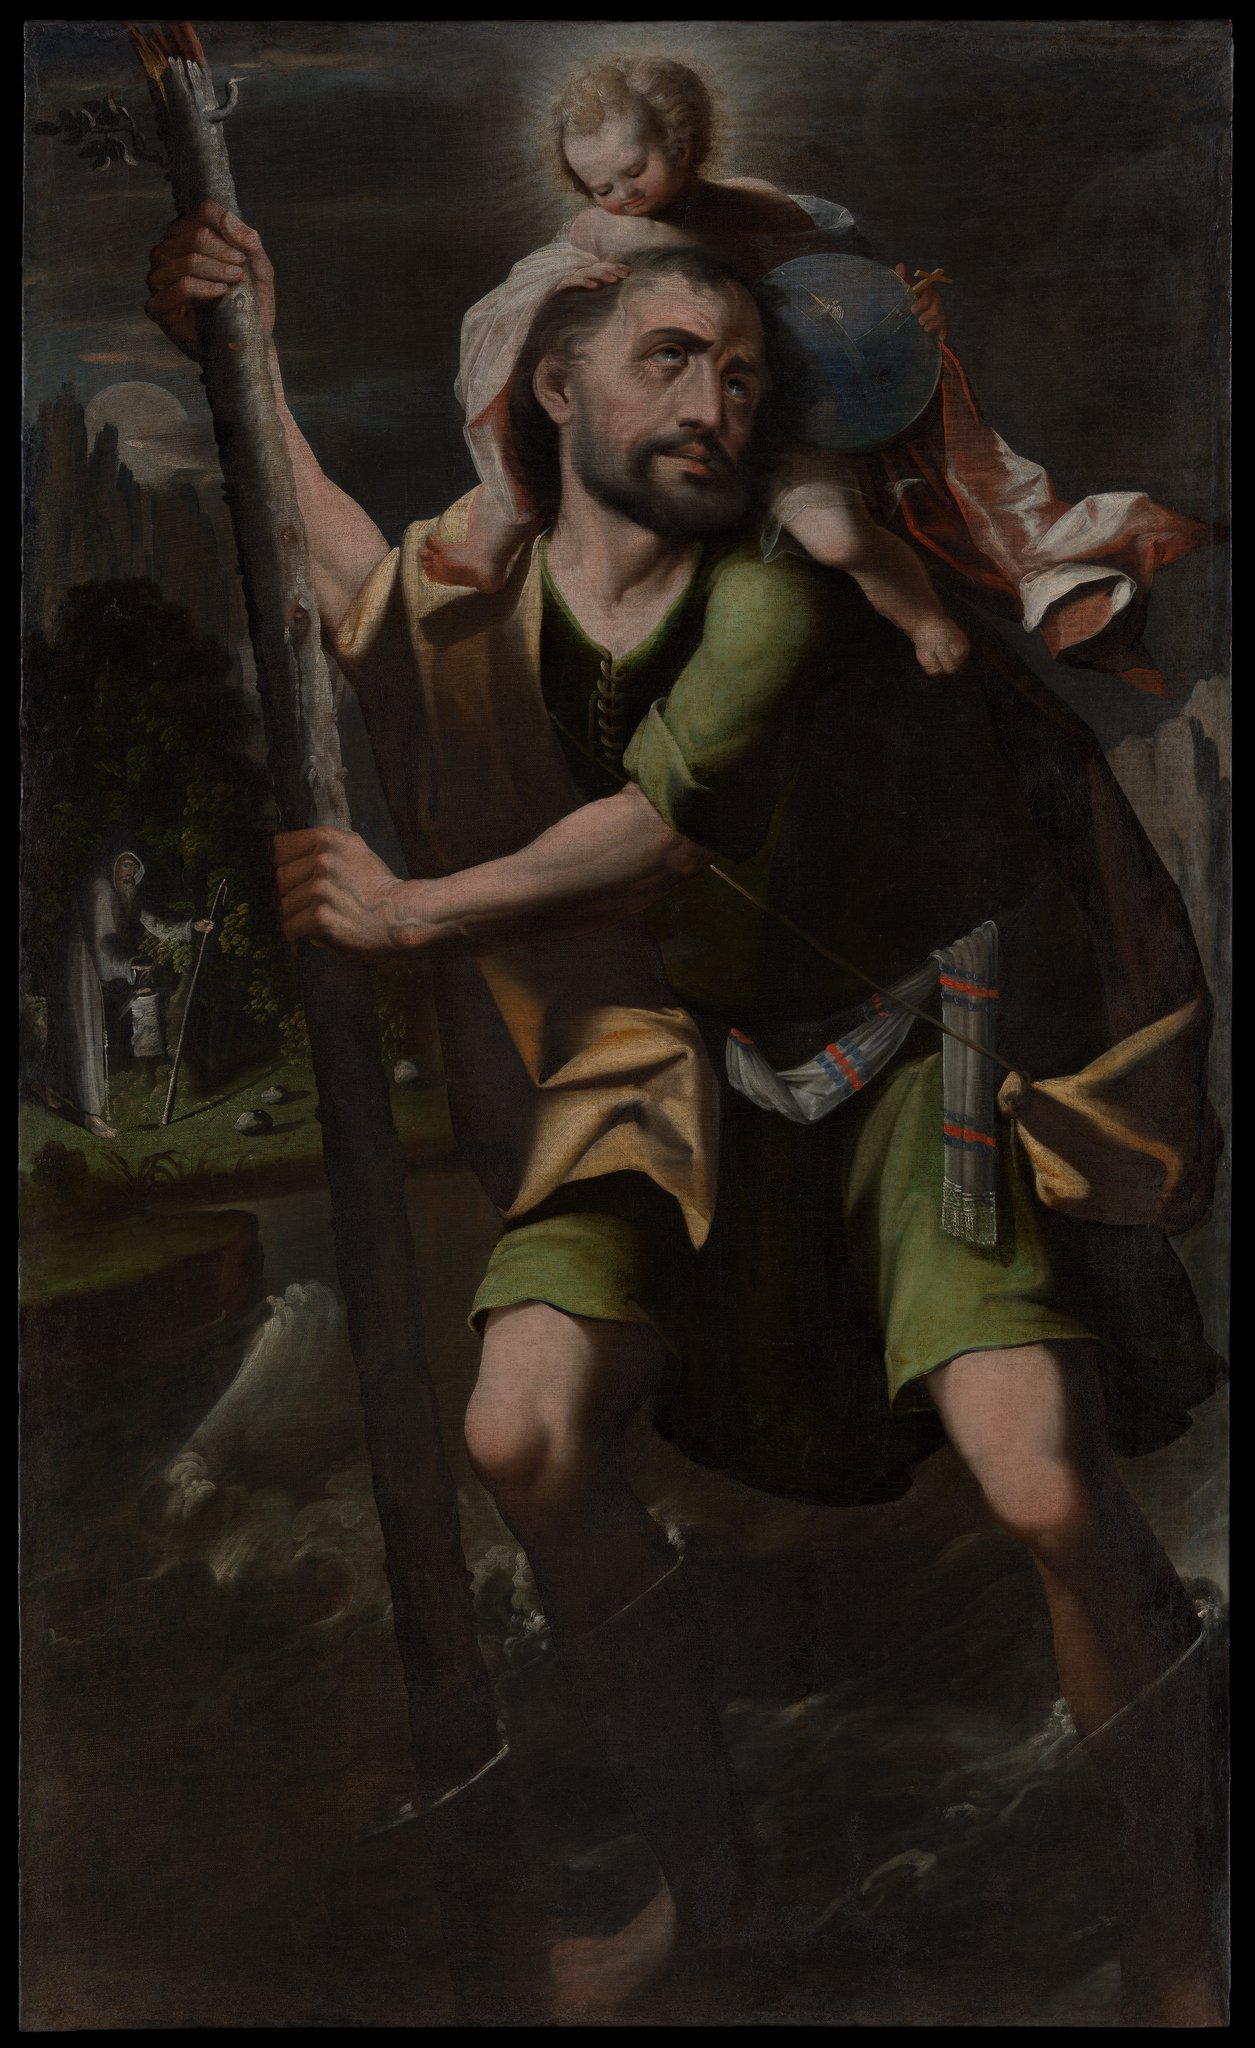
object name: painting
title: Saint Christopher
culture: bolivian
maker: melchor pérez holguin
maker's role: artist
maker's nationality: bolivian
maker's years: 1660-1732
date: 1710-1720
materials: canvas, oil